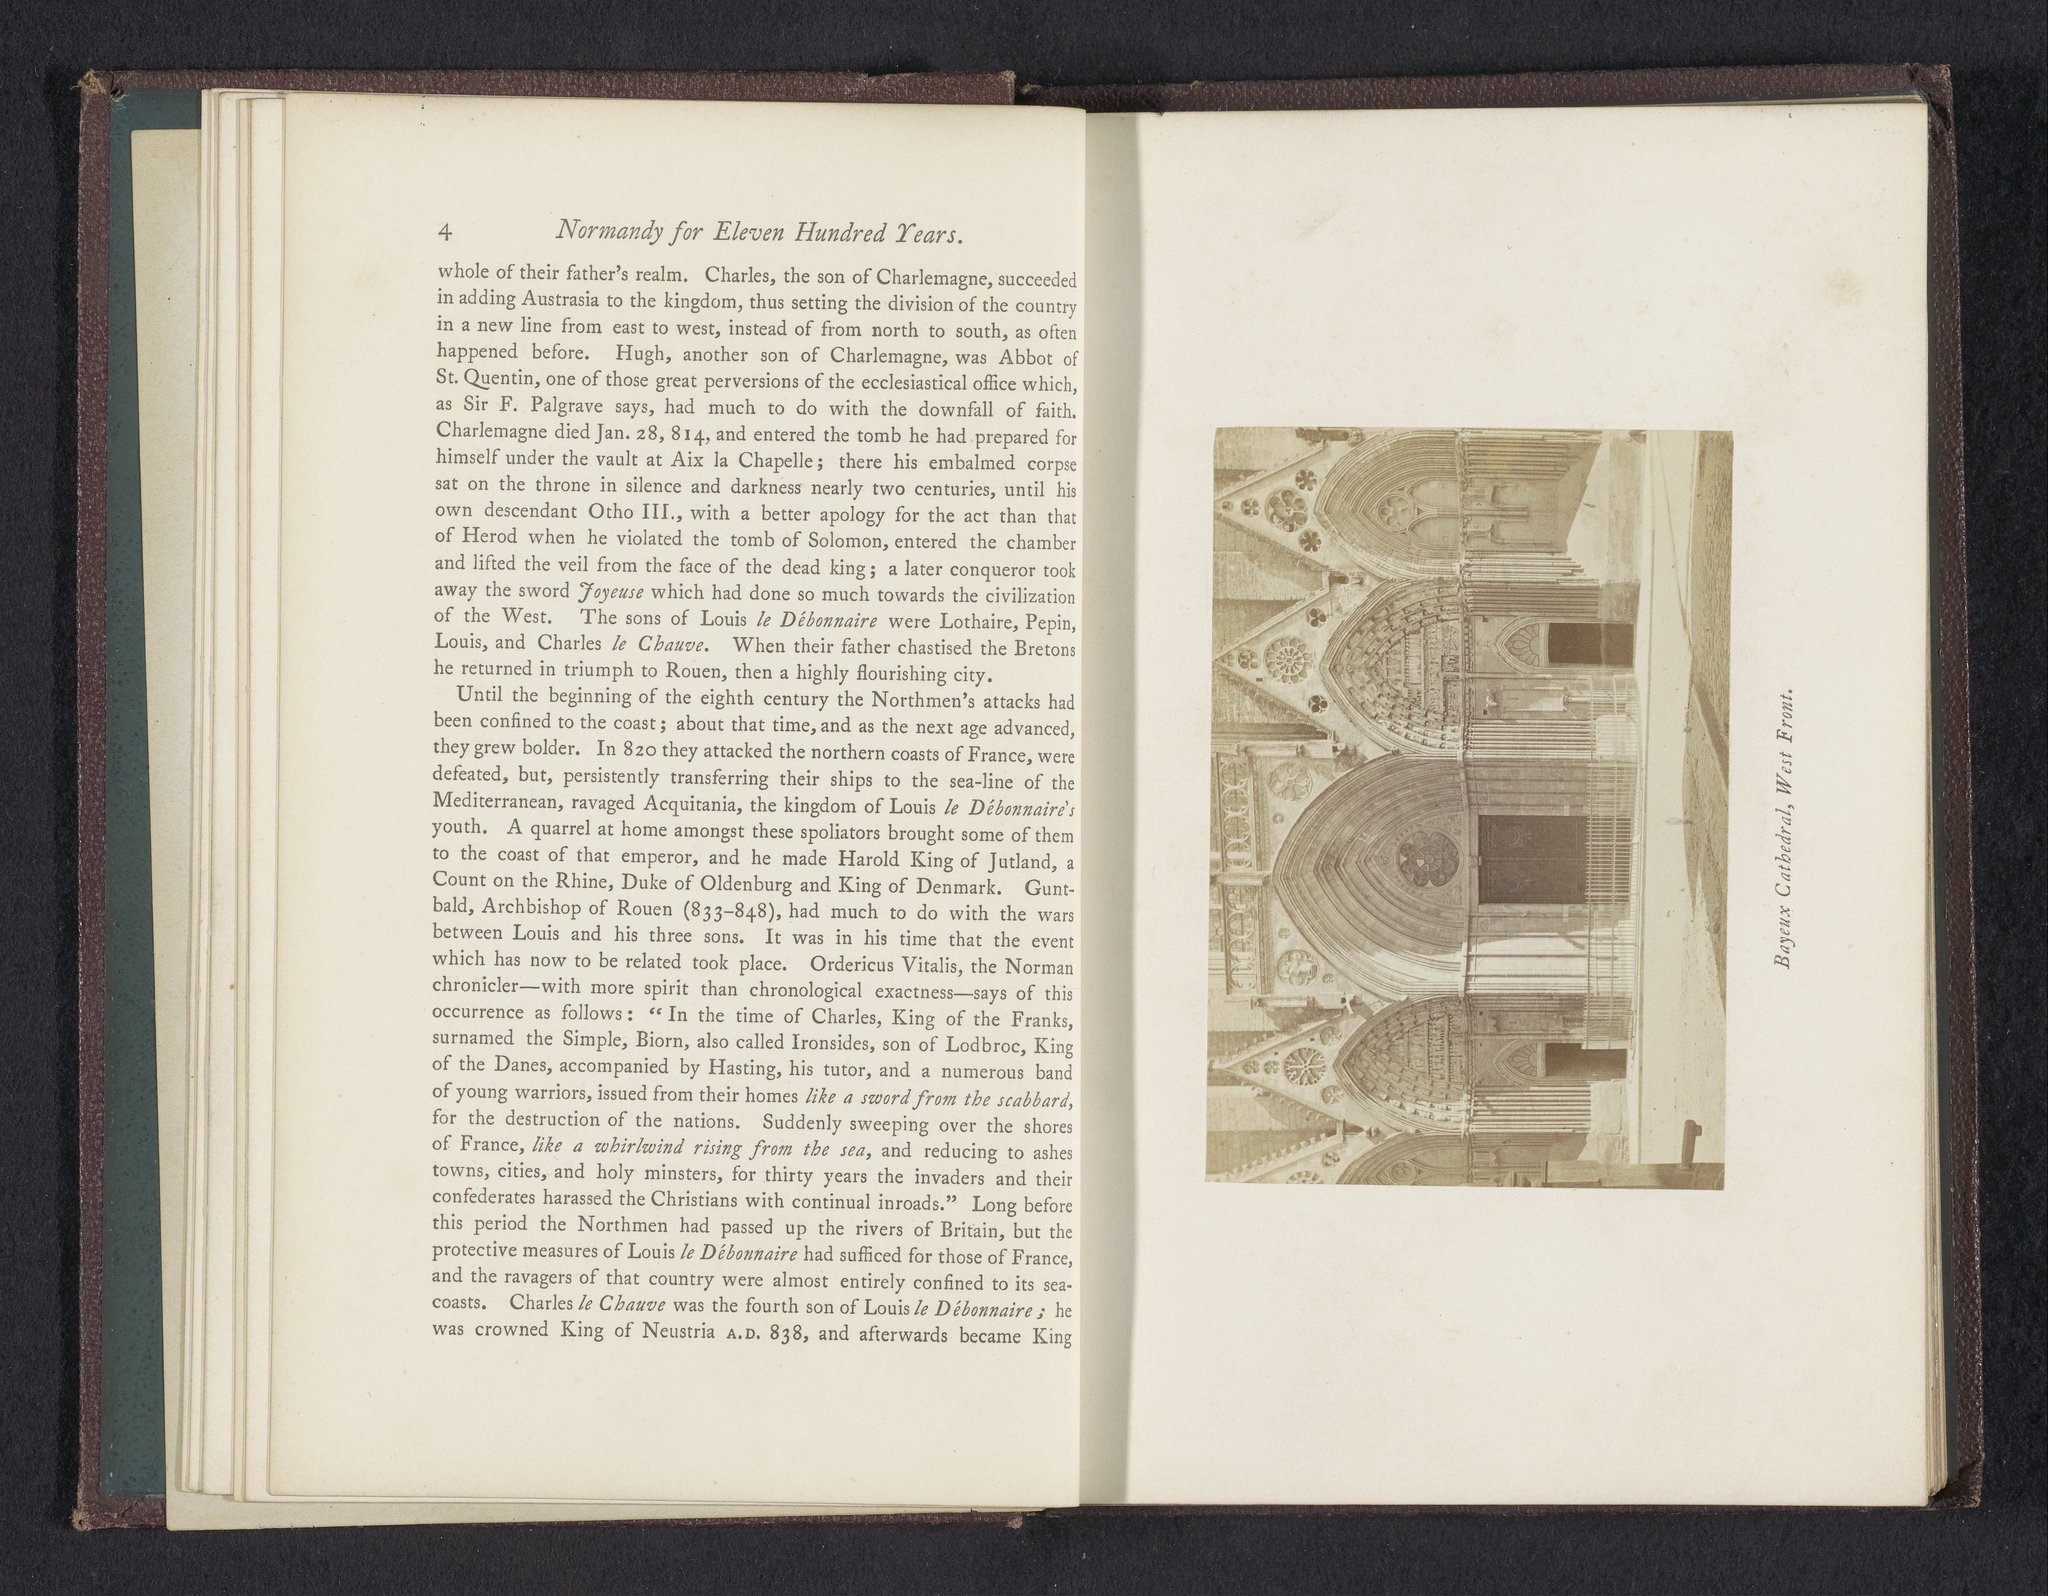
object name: page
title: Bayeux Cathedral, West front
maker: joseph cundall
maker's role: fotograaf, schrijver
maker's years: 1818-1895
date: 1855-1865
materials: photographic support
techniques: albumen print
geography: bayeux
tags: parts of church exterior and annexes: portal, façade (of house or building)